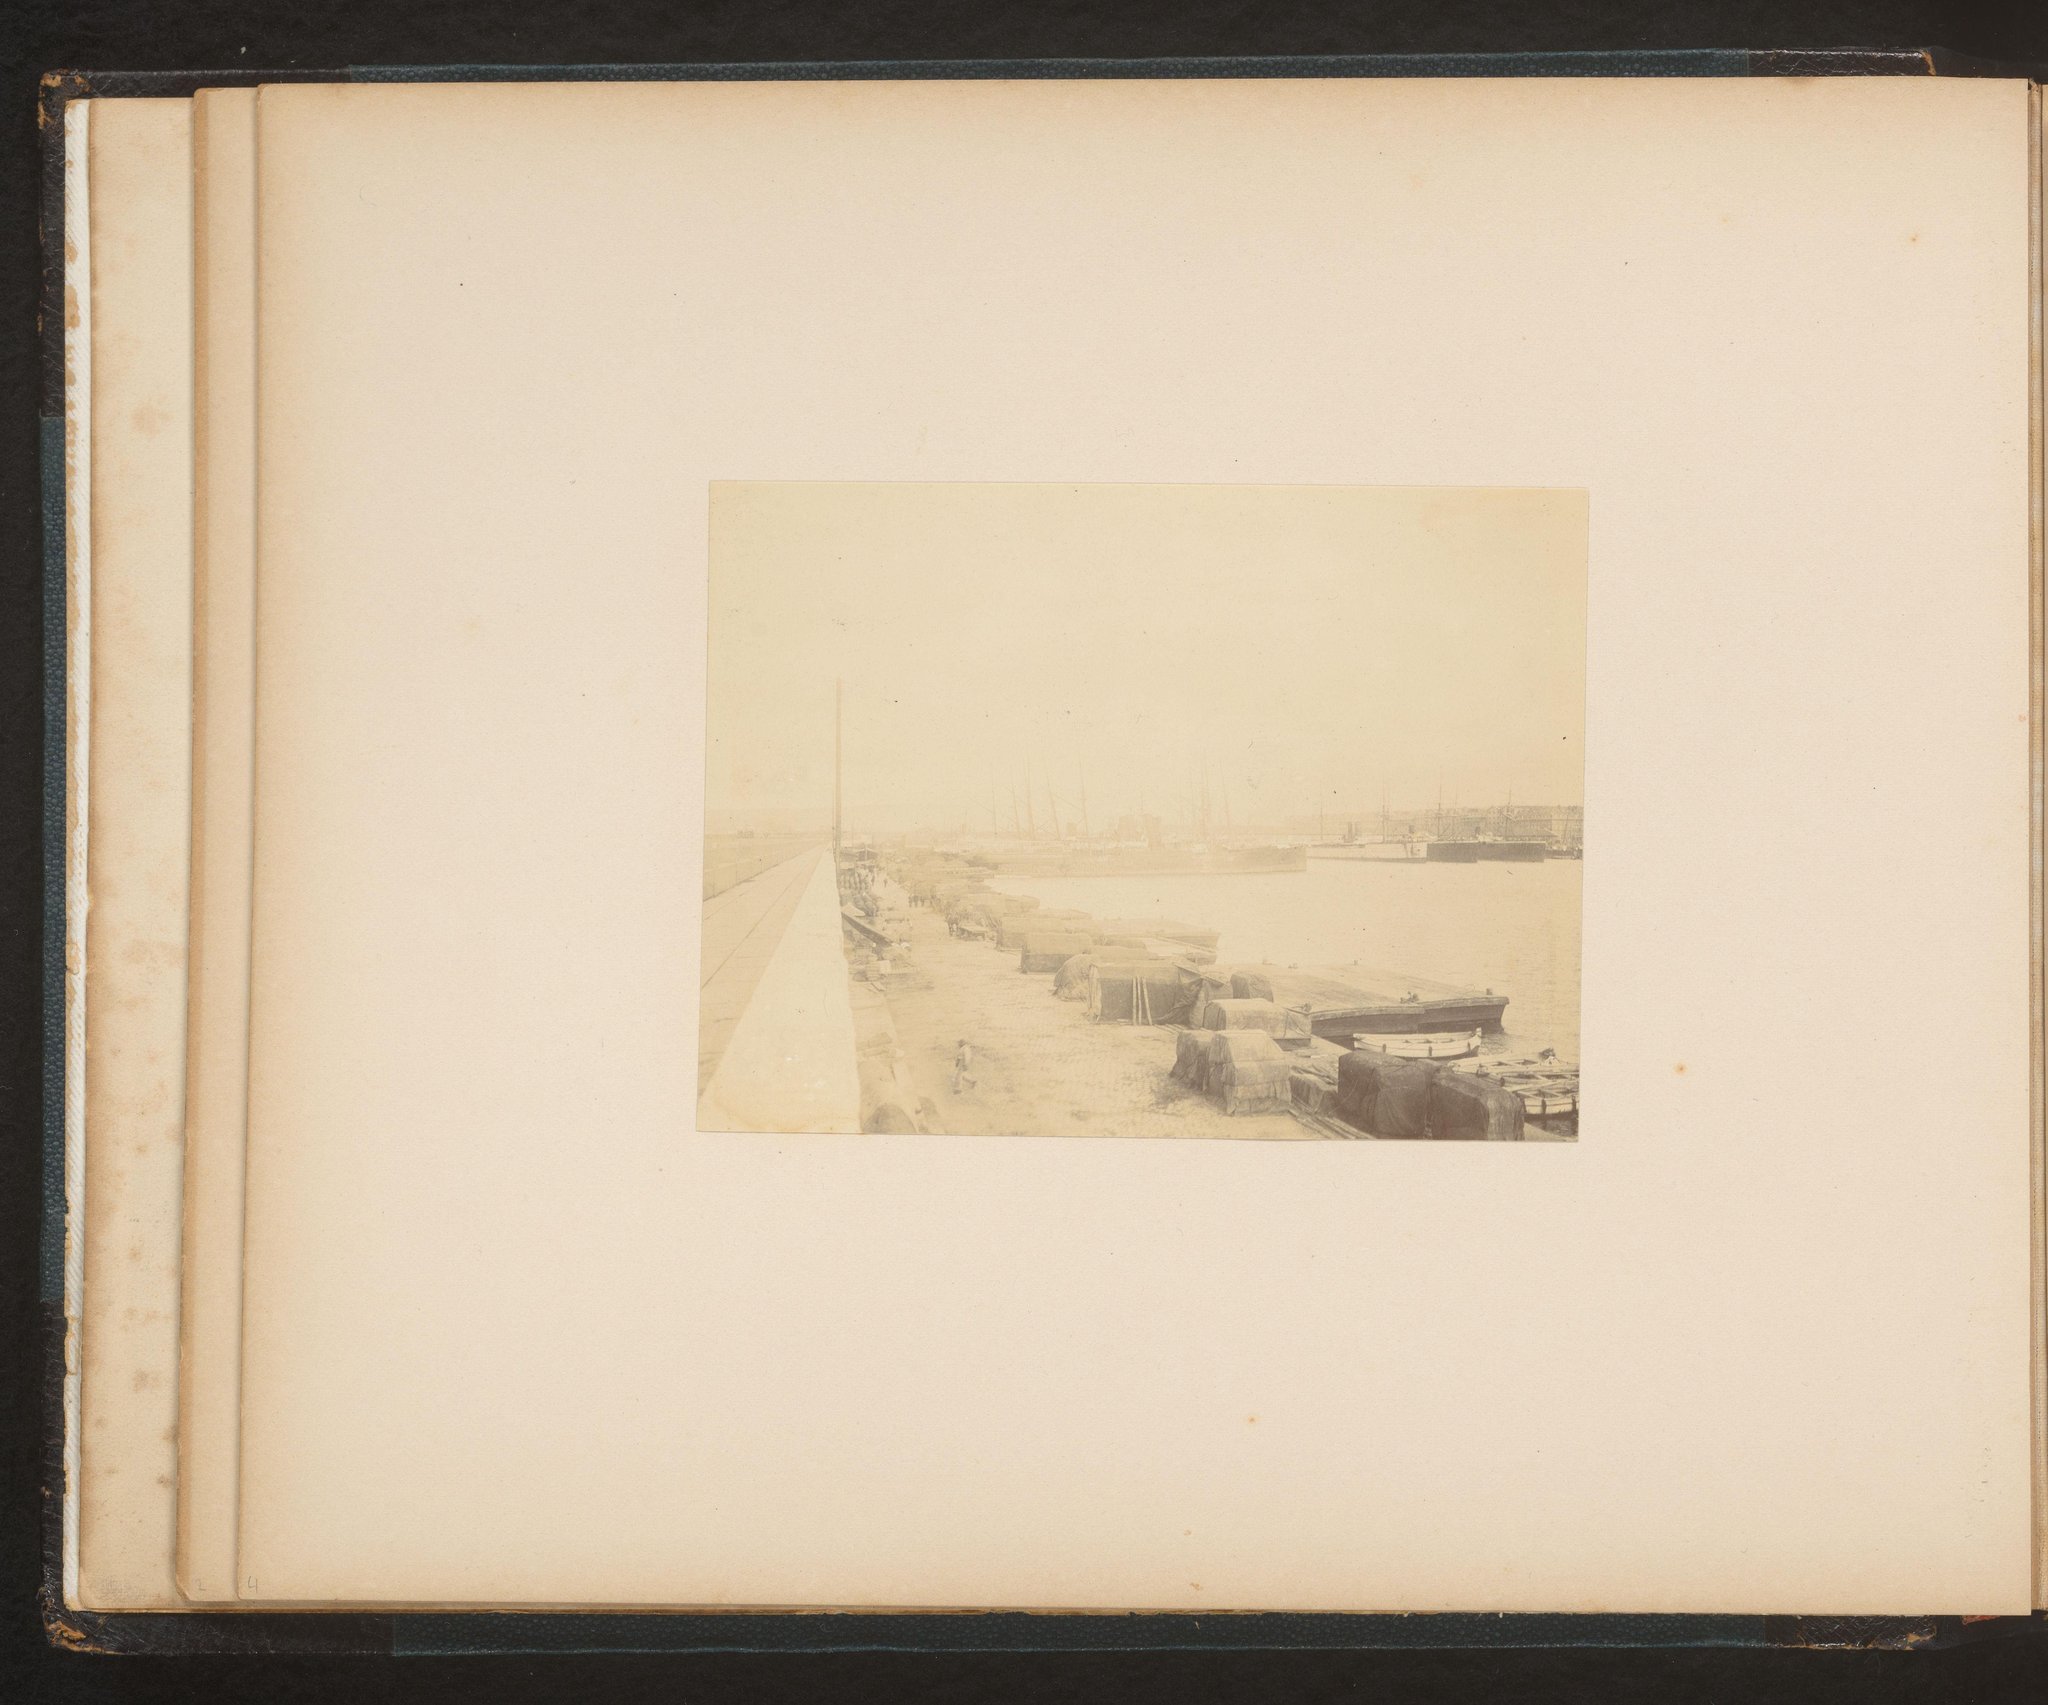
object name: album leaf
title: Boten in een haven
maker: Anonymous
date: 1880-1920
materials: cardboard, photographic support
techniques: gelatin silver print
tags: harbour, ships (in general), france